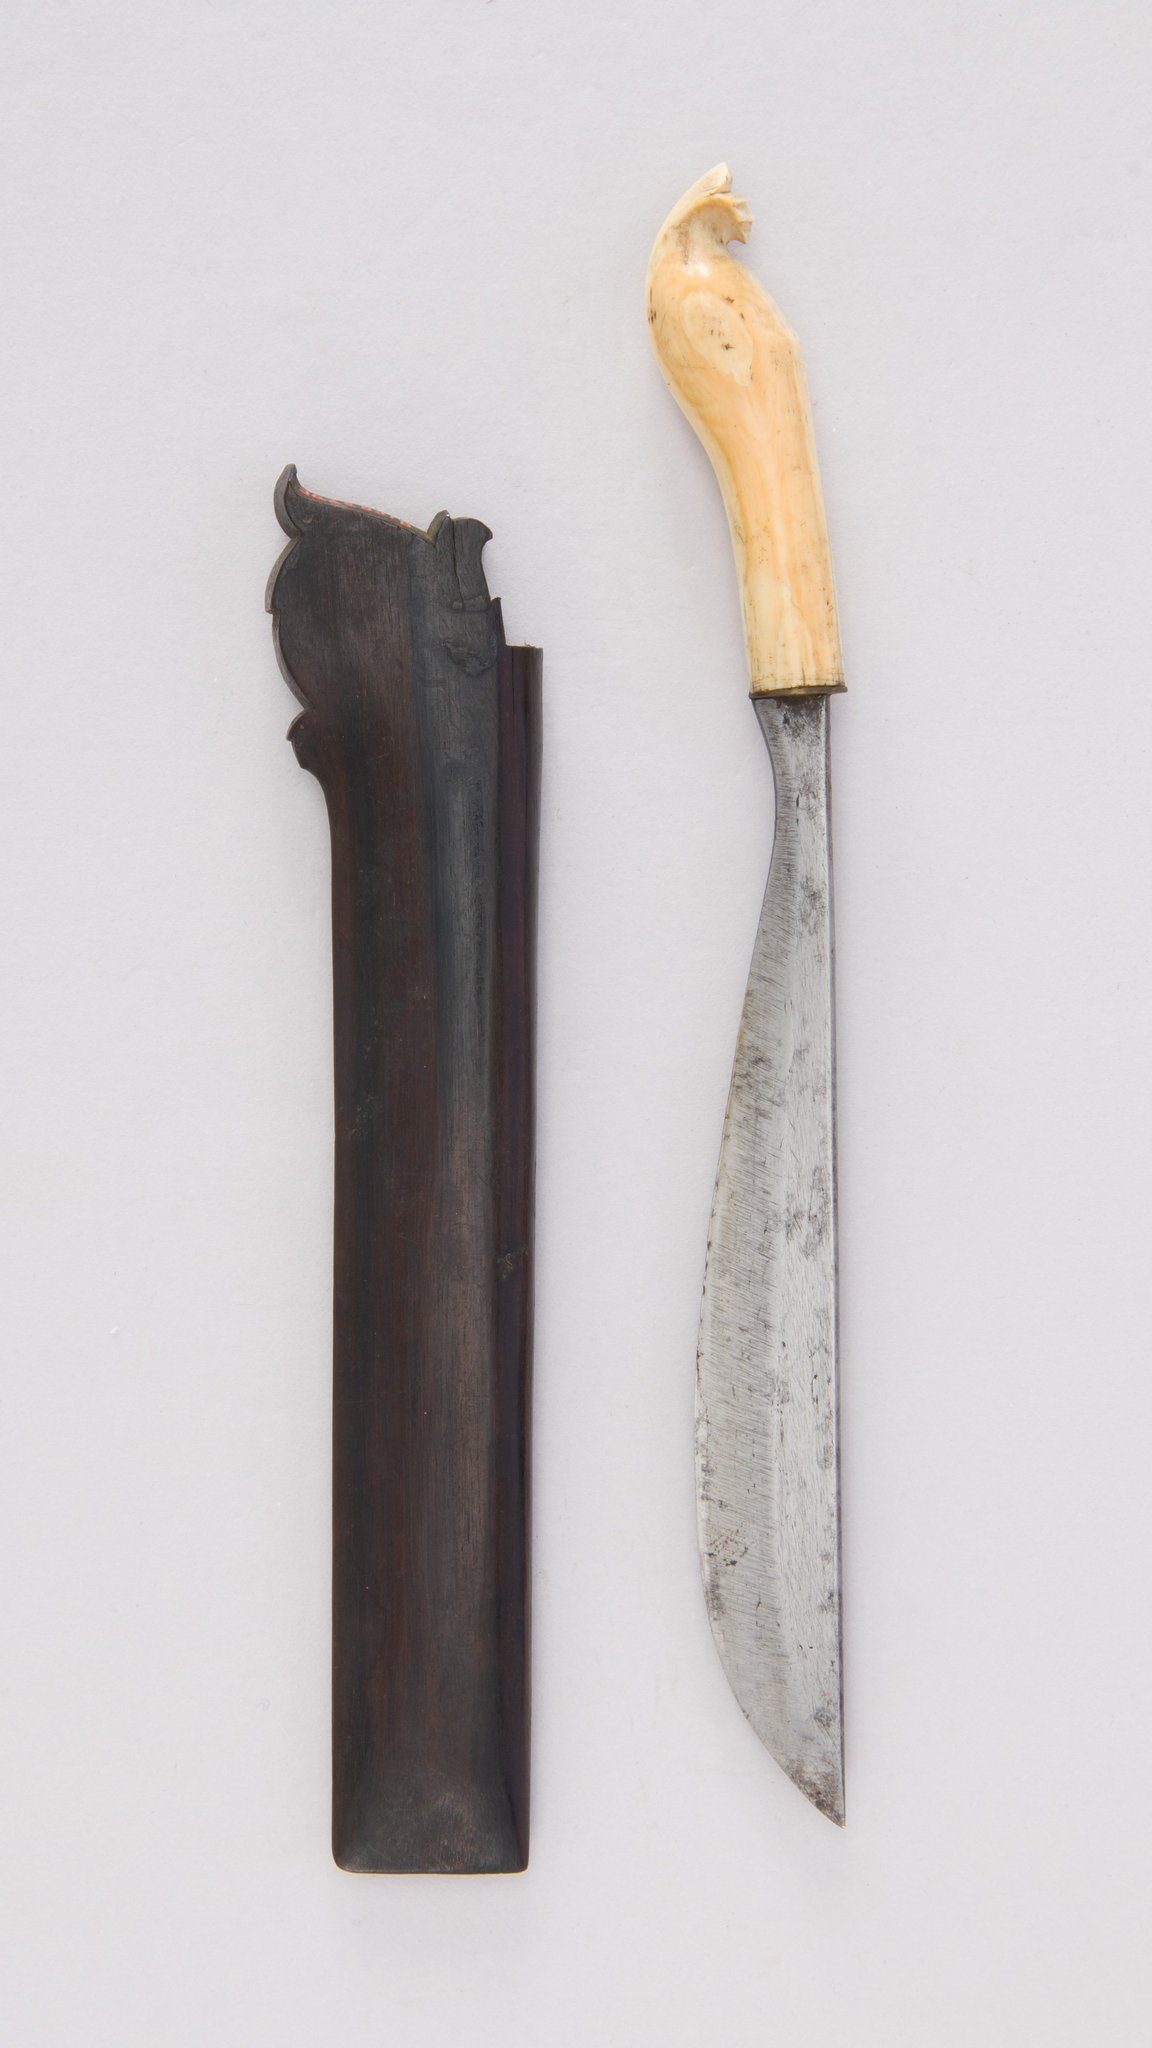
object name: knife golok with sheath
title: Knife (Golok) with Sheath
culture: malayan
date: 1701-1900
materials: ivory, wood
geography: malaysia